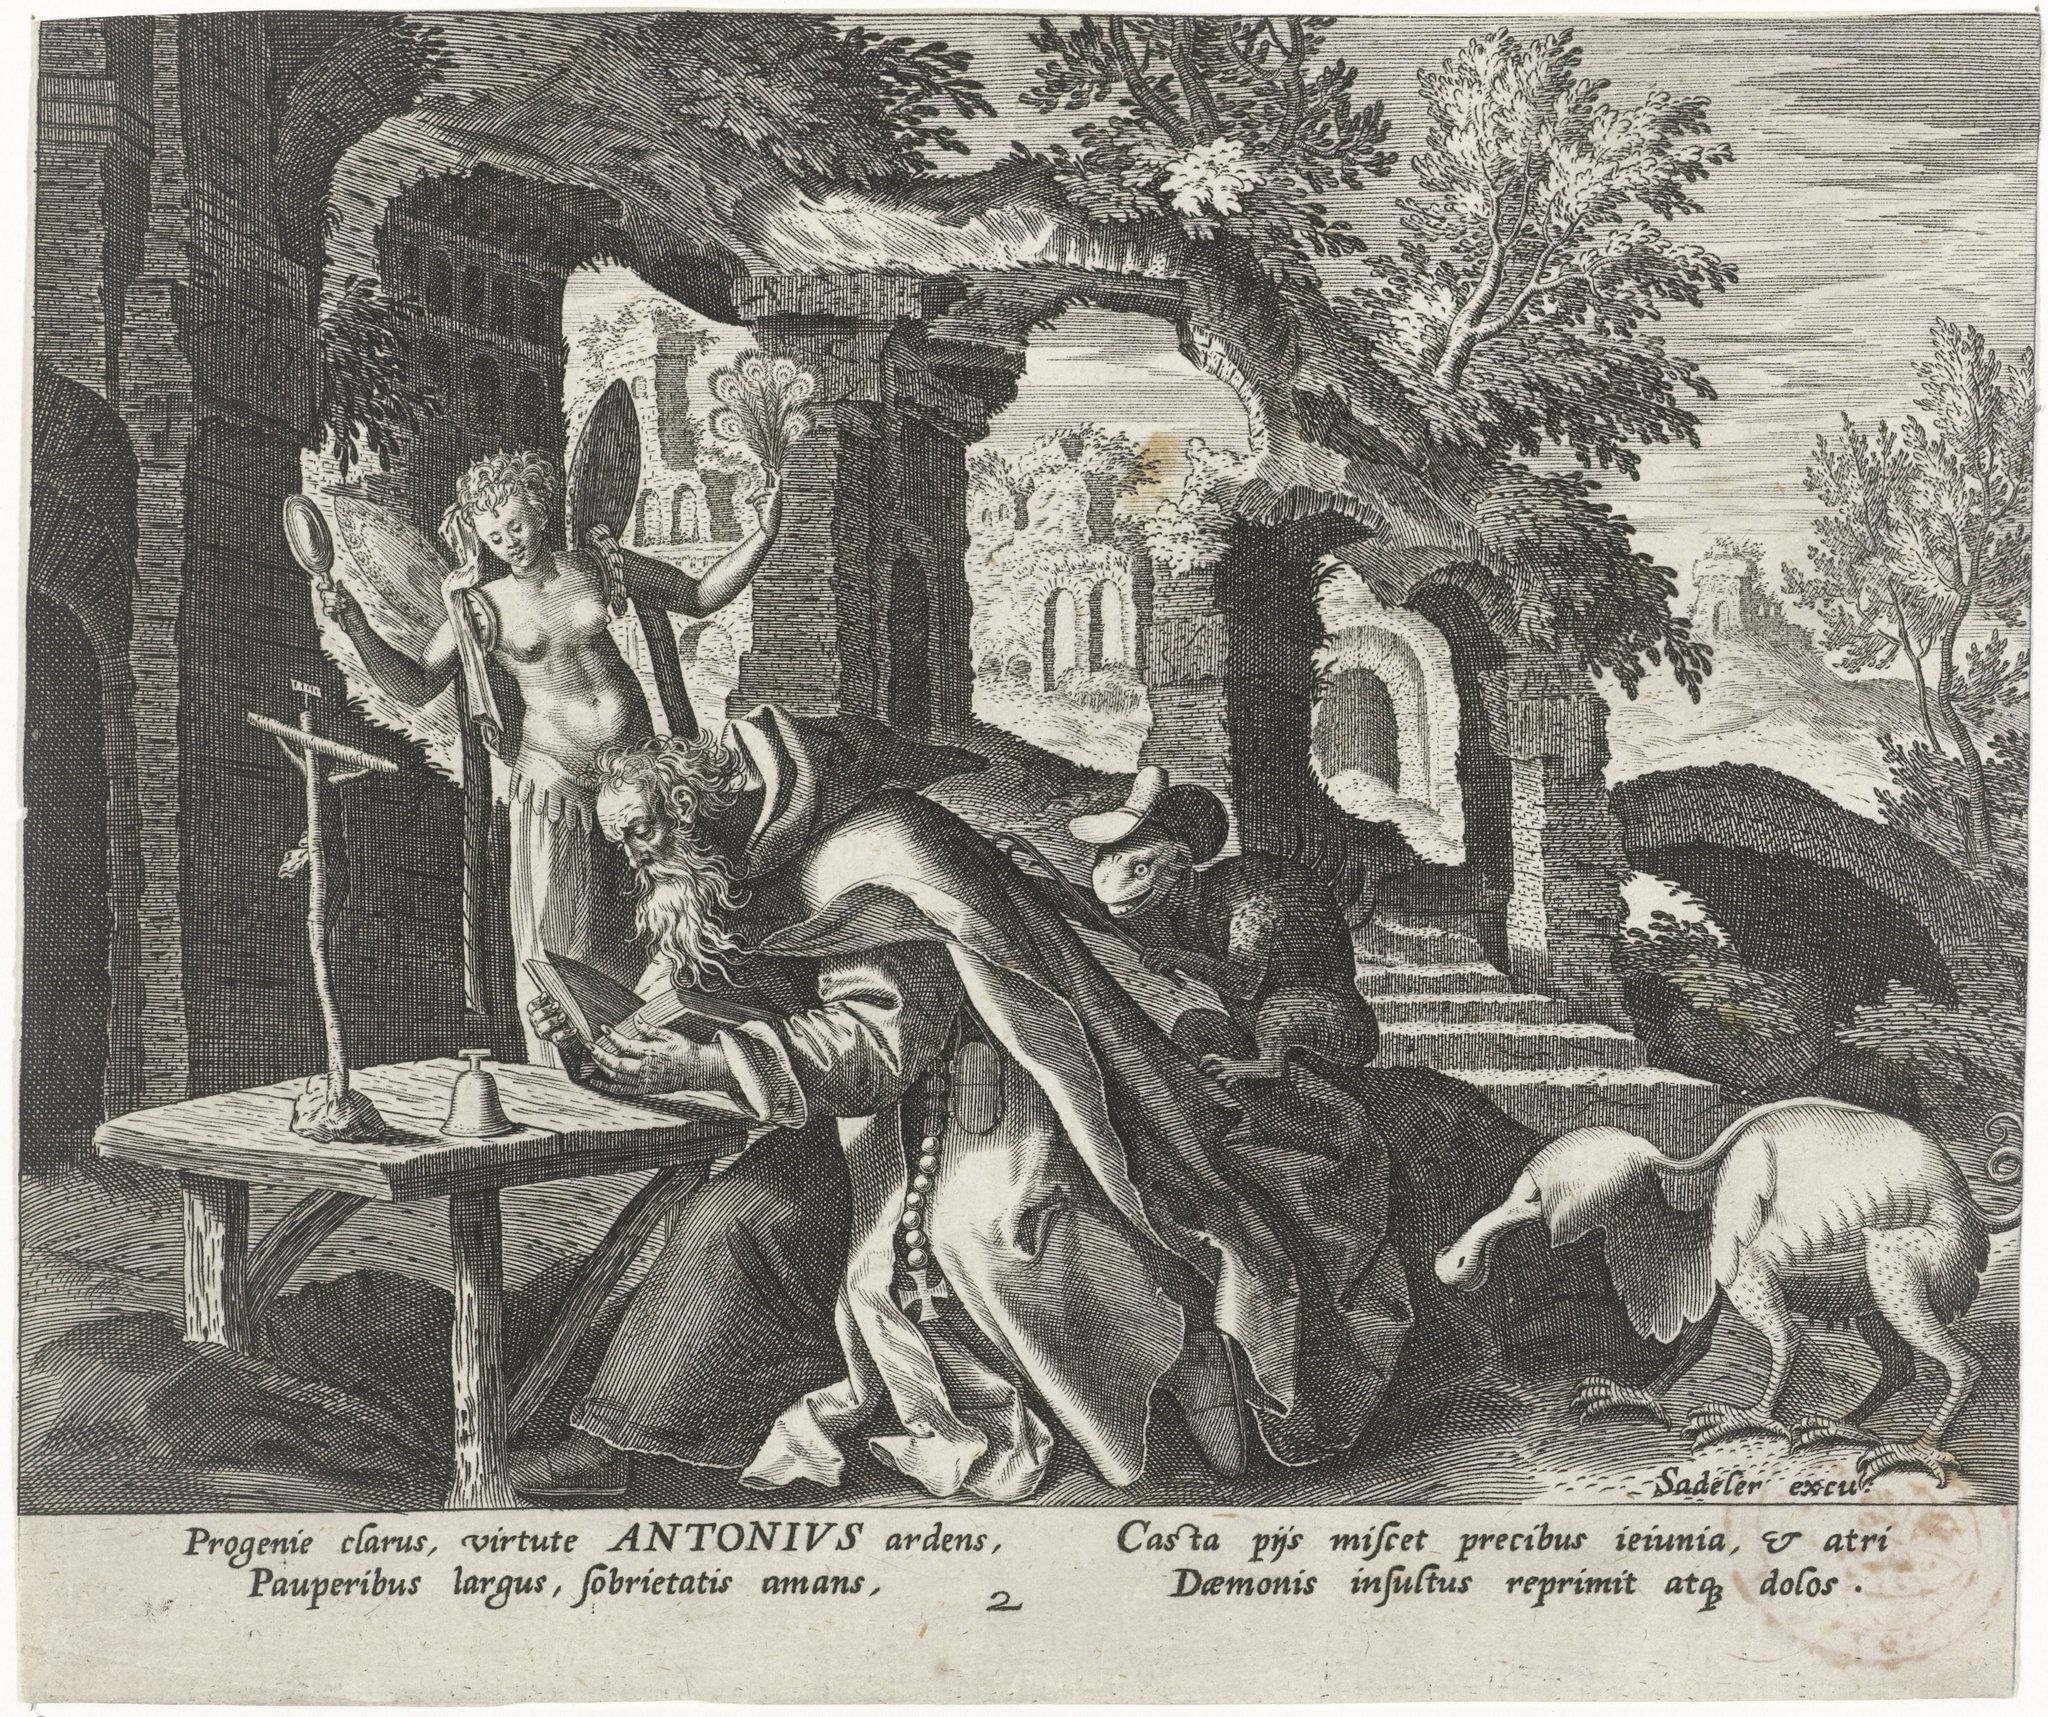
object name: print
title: Solitudo Sive Vitae Patrum Eremicolarum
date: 1583-1588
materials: paper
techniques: engraving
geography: antwerp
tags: temptations of st. antony abbot, anchorite, hermit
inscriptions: collector's mark: Lugt 240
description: De H. Antonius de Grote voor een crucifix in een ruïne. Hij leest in een bijbel en wordt geplaagd door duiveltjes en een mooie vrouw met een spiegel.